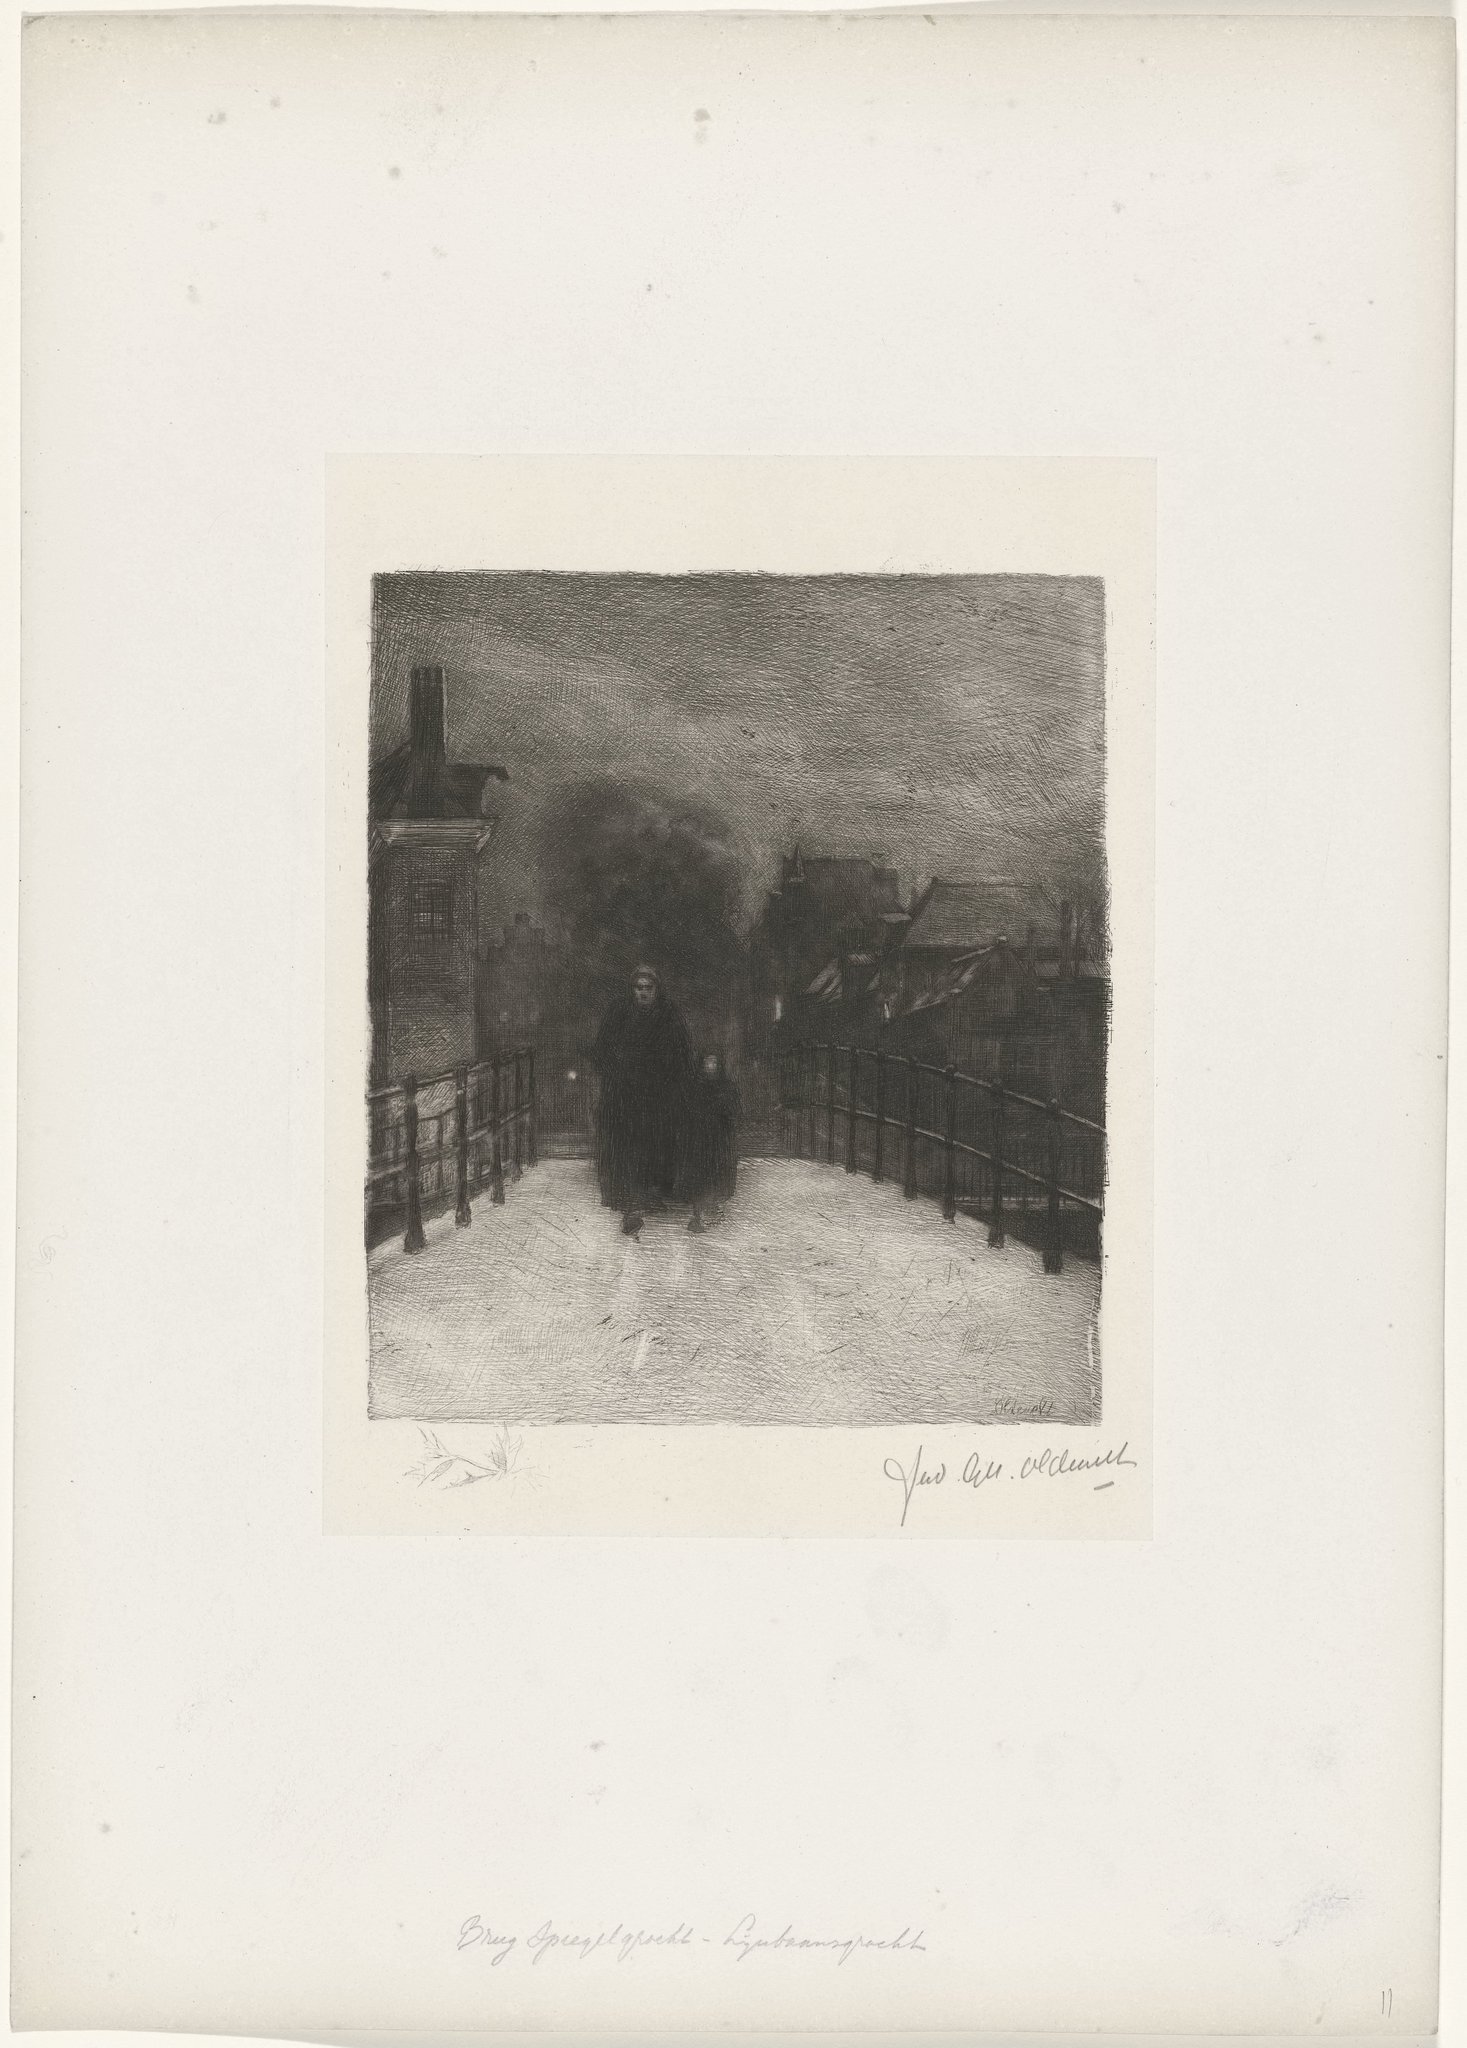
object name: print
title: Oude vrouw met kind op een brug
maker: ferdinand oldewelt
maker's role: draughtsman, print maker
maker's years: 1857-1935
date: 1888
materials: paper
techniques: drypoint, etching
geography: netherlands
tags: frost, freezing weather, old woman, the poor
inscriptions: collector's mark: Lugt 2228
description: Wintergezicht met een oude vrouw en een kind die over een brug lopen. Waarschijnlijk de brug op de hoek van de Spiegelgracht en de Lijnbaansgracht in Amsterdam.